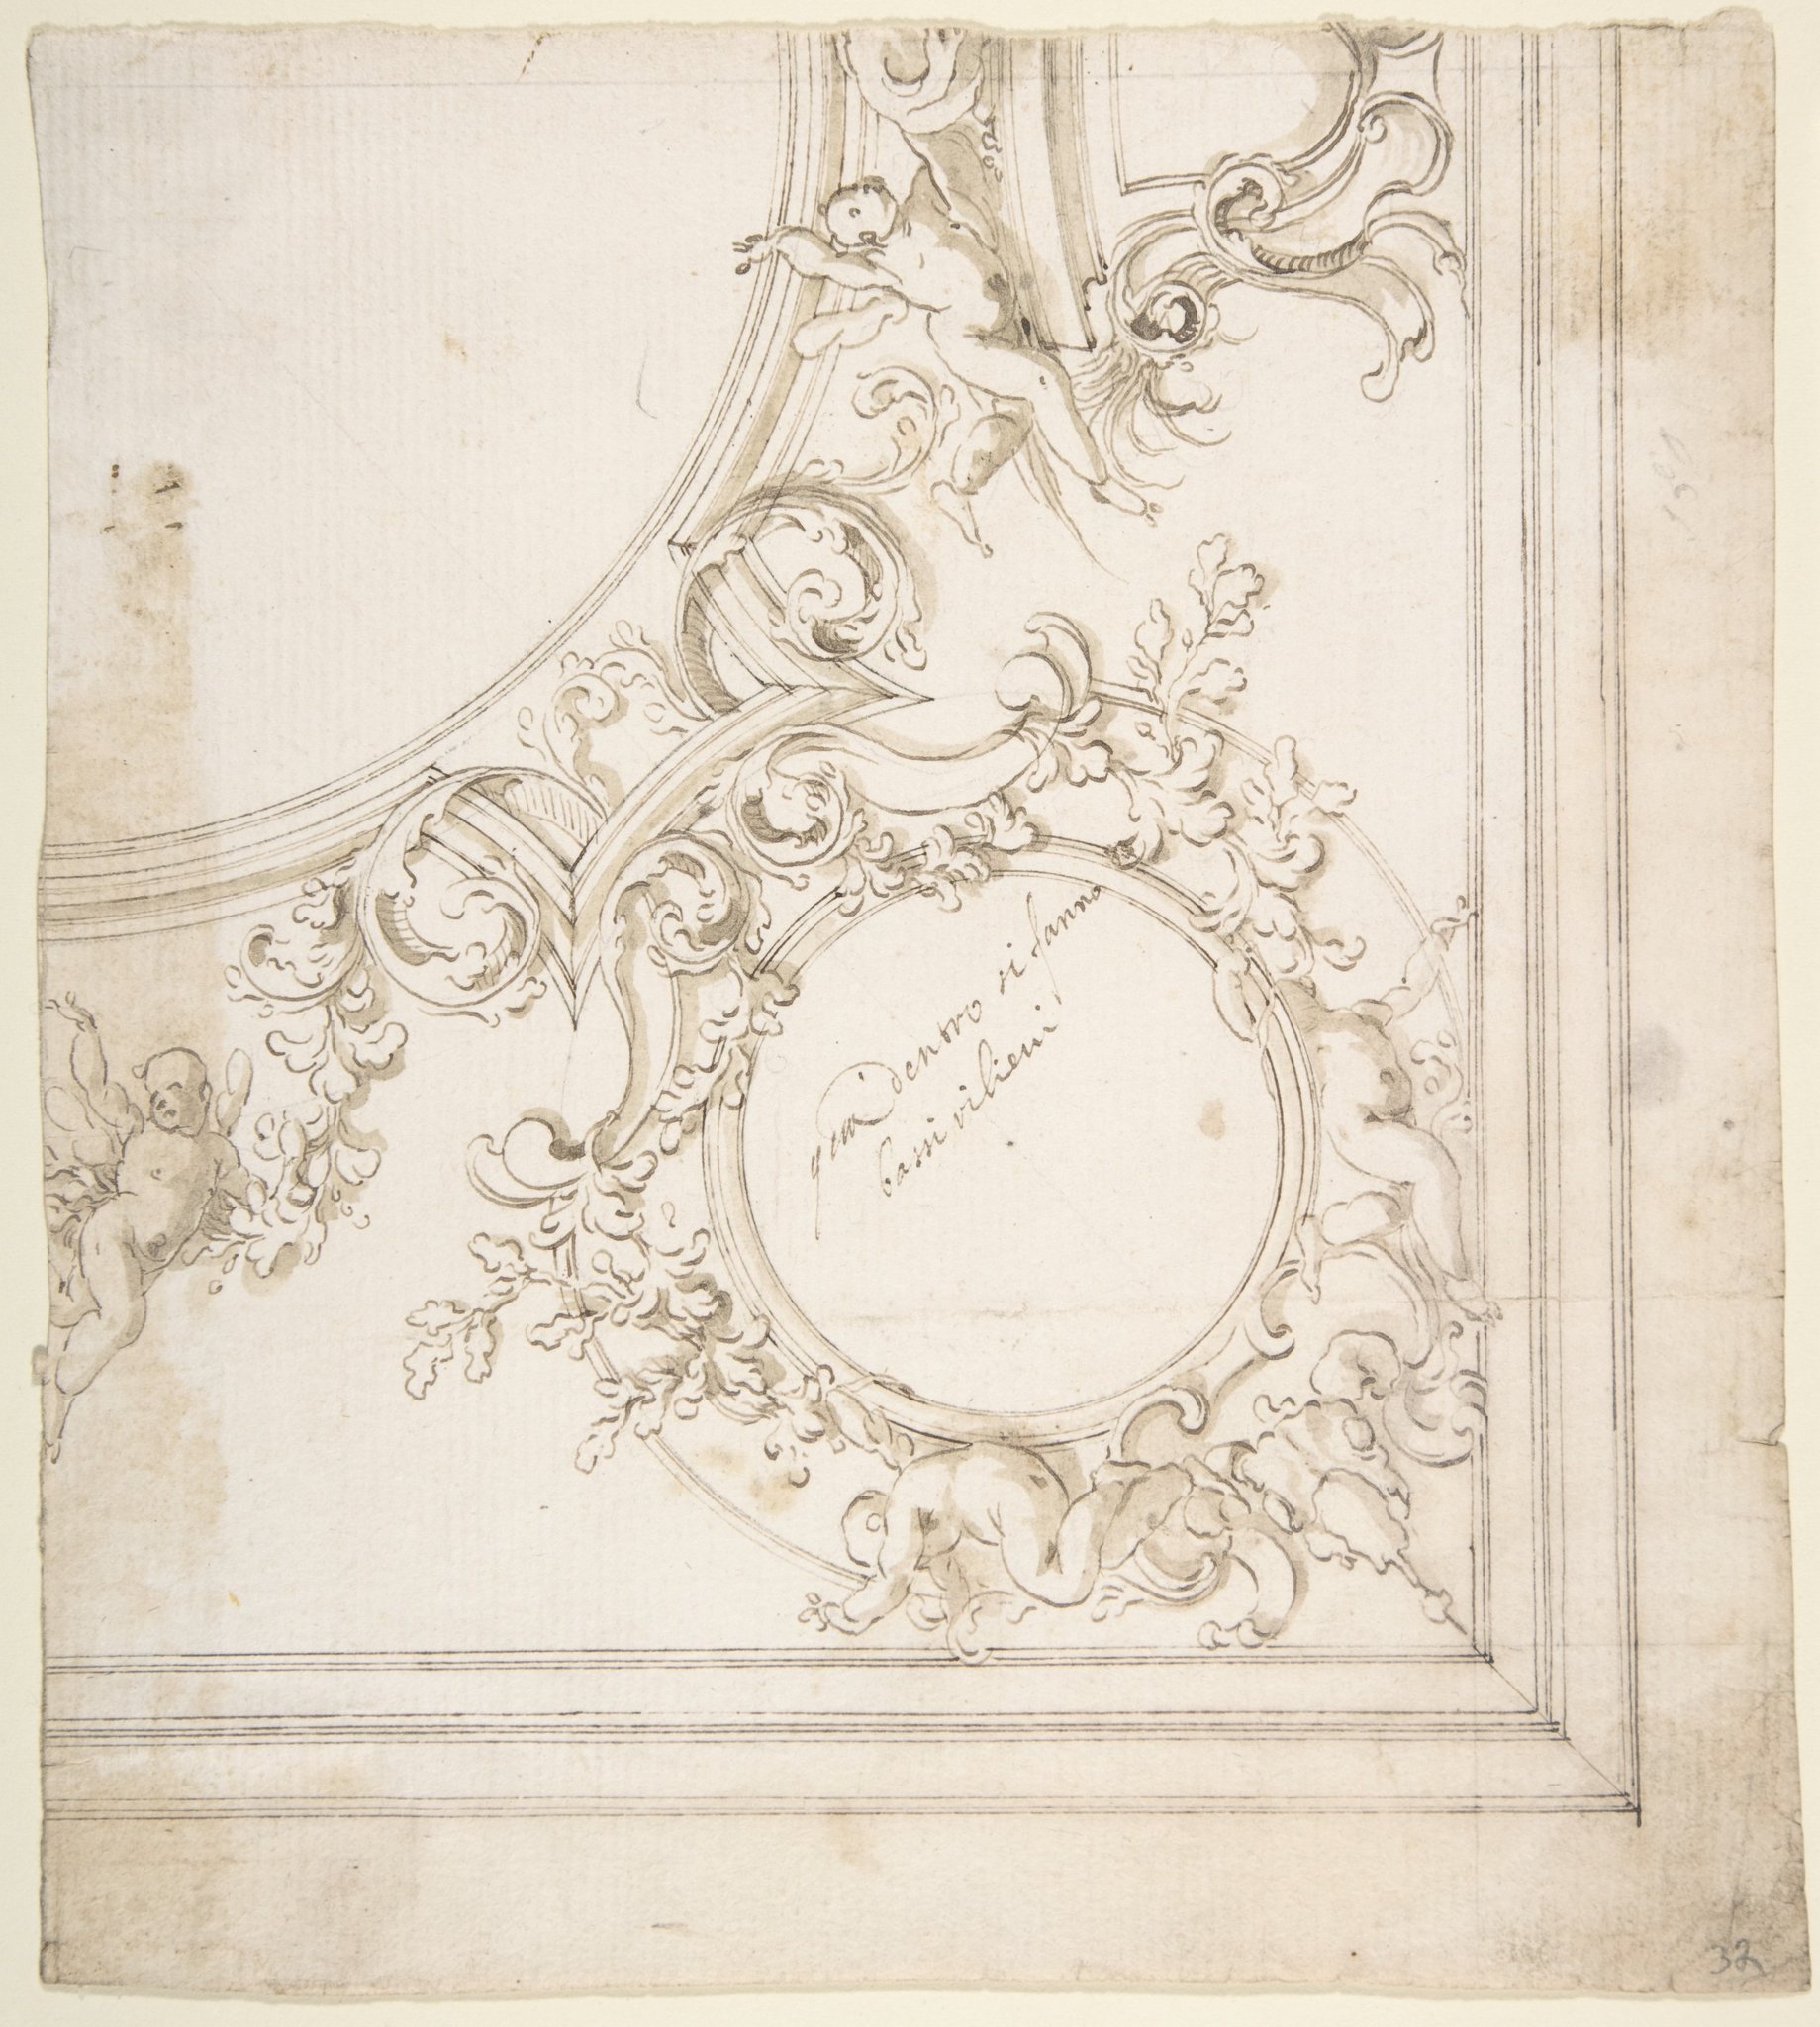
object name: drawing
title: Design for a Ceiling Decoration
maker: donato giuseppe frisoni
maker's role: artist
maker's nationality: italian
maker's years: 1683-1735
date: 1709-1720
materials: graphite, ink, drawing material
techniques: brush, pen, wash